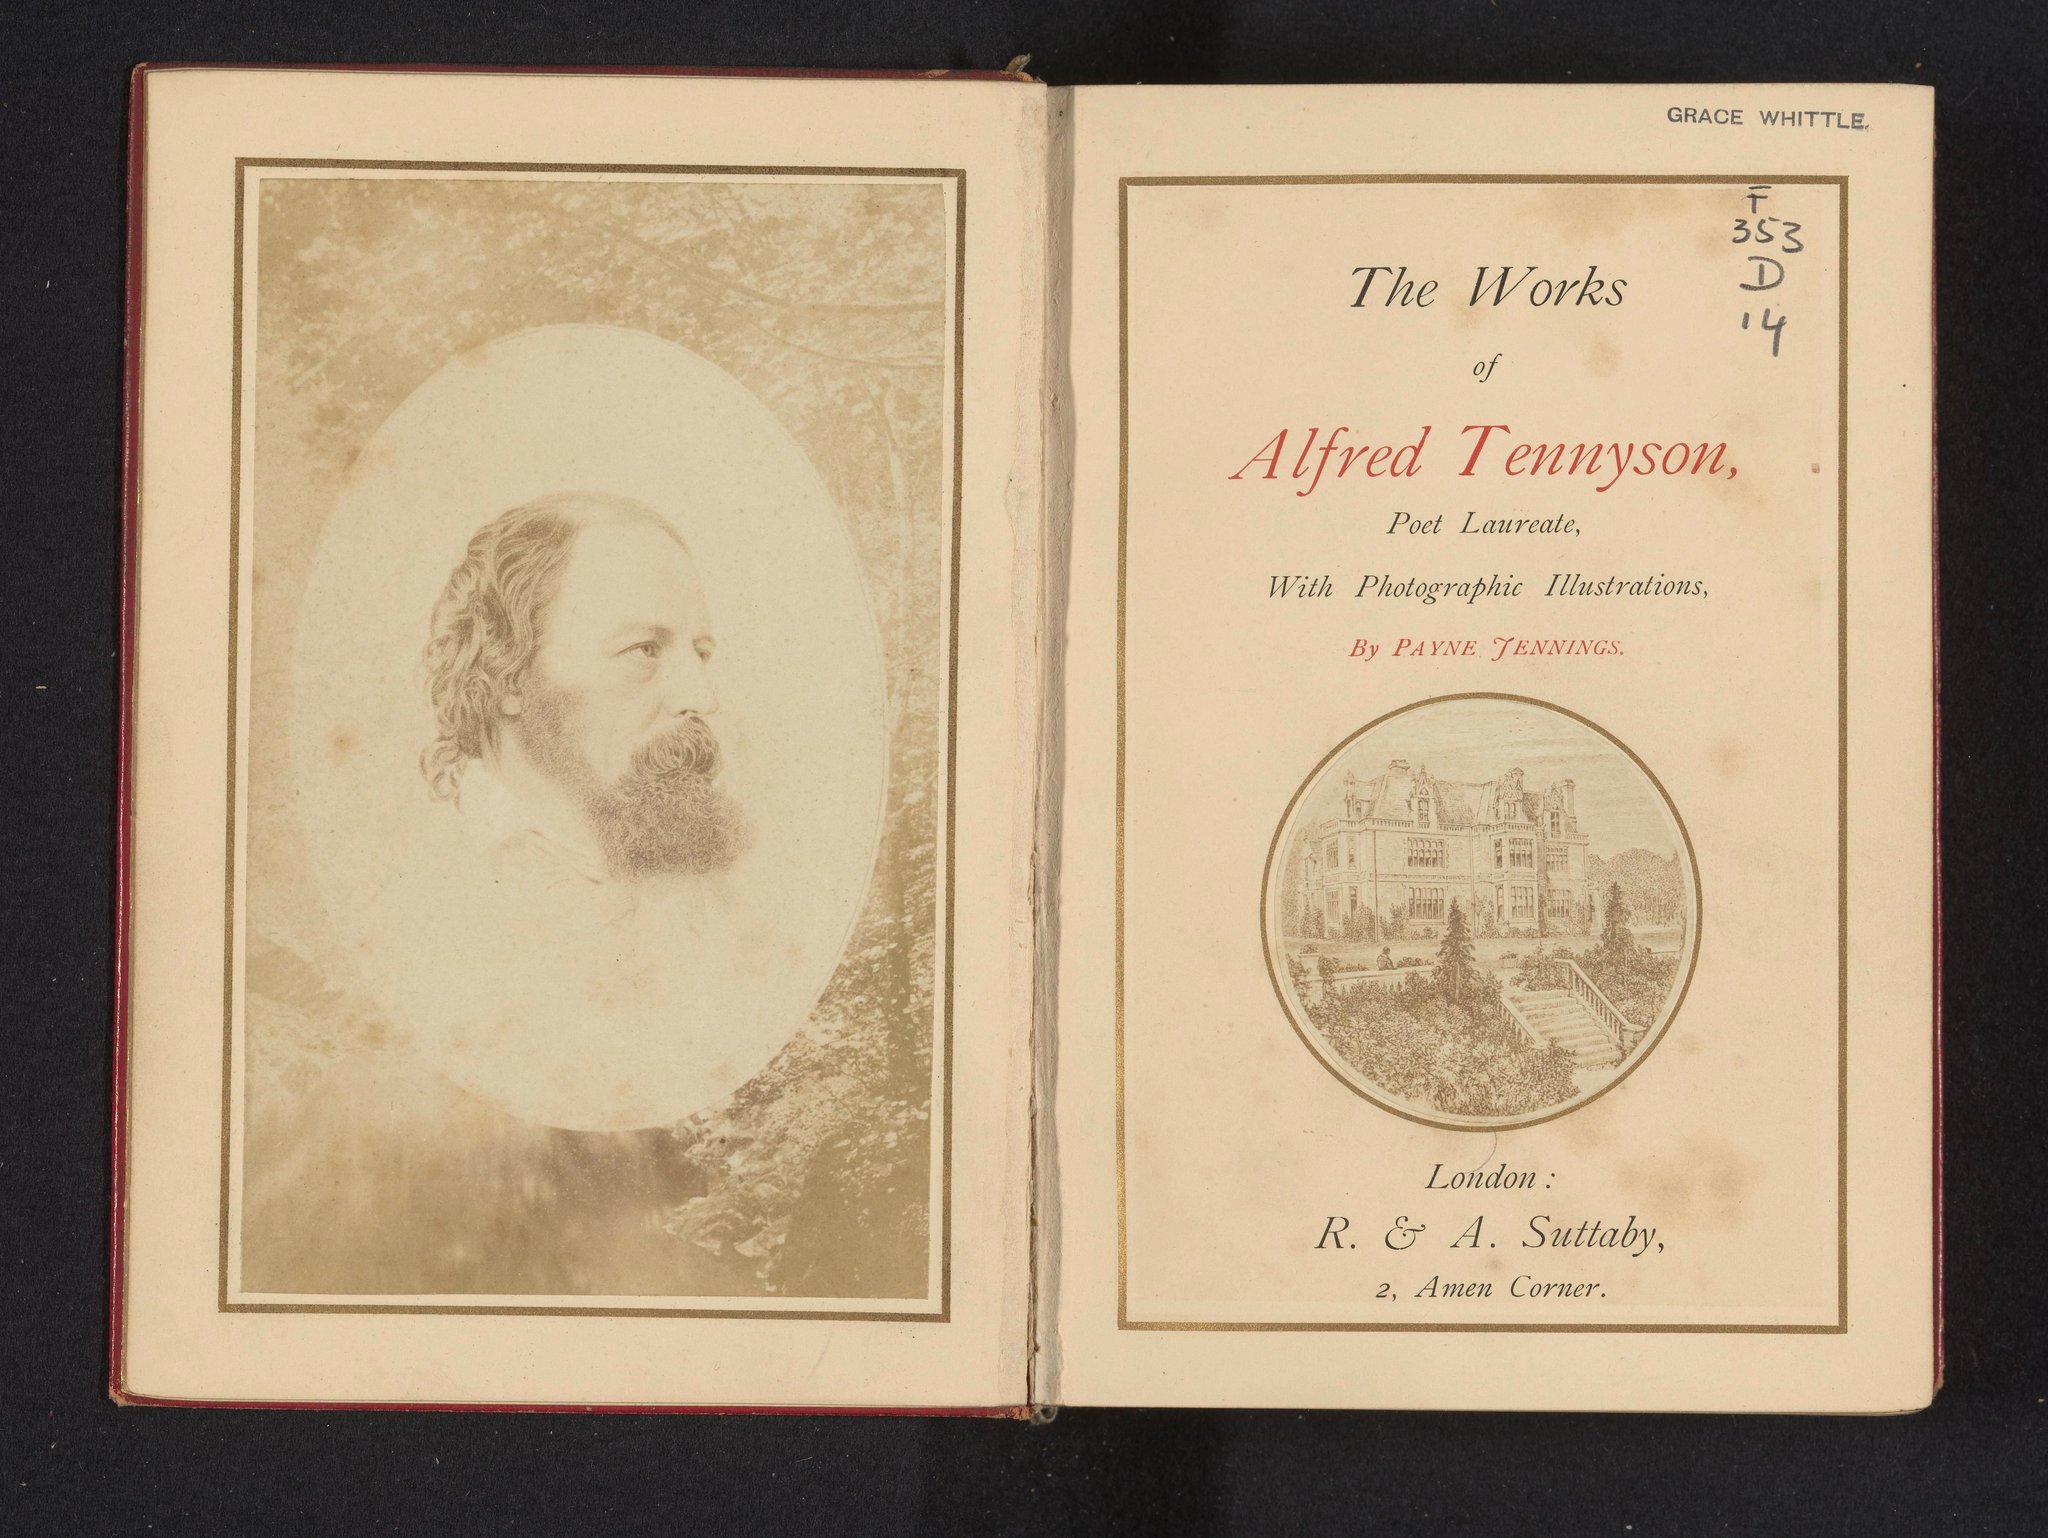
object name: page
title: Fotoreproductie van een tekening, voorstellende een portret van Alfred Tennyson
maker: john payne jennings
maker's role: fotograaf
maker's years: 1843-1926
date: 1873-1878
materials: photographic support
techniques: albumen print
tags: alfred tennyson, portrait of a writer